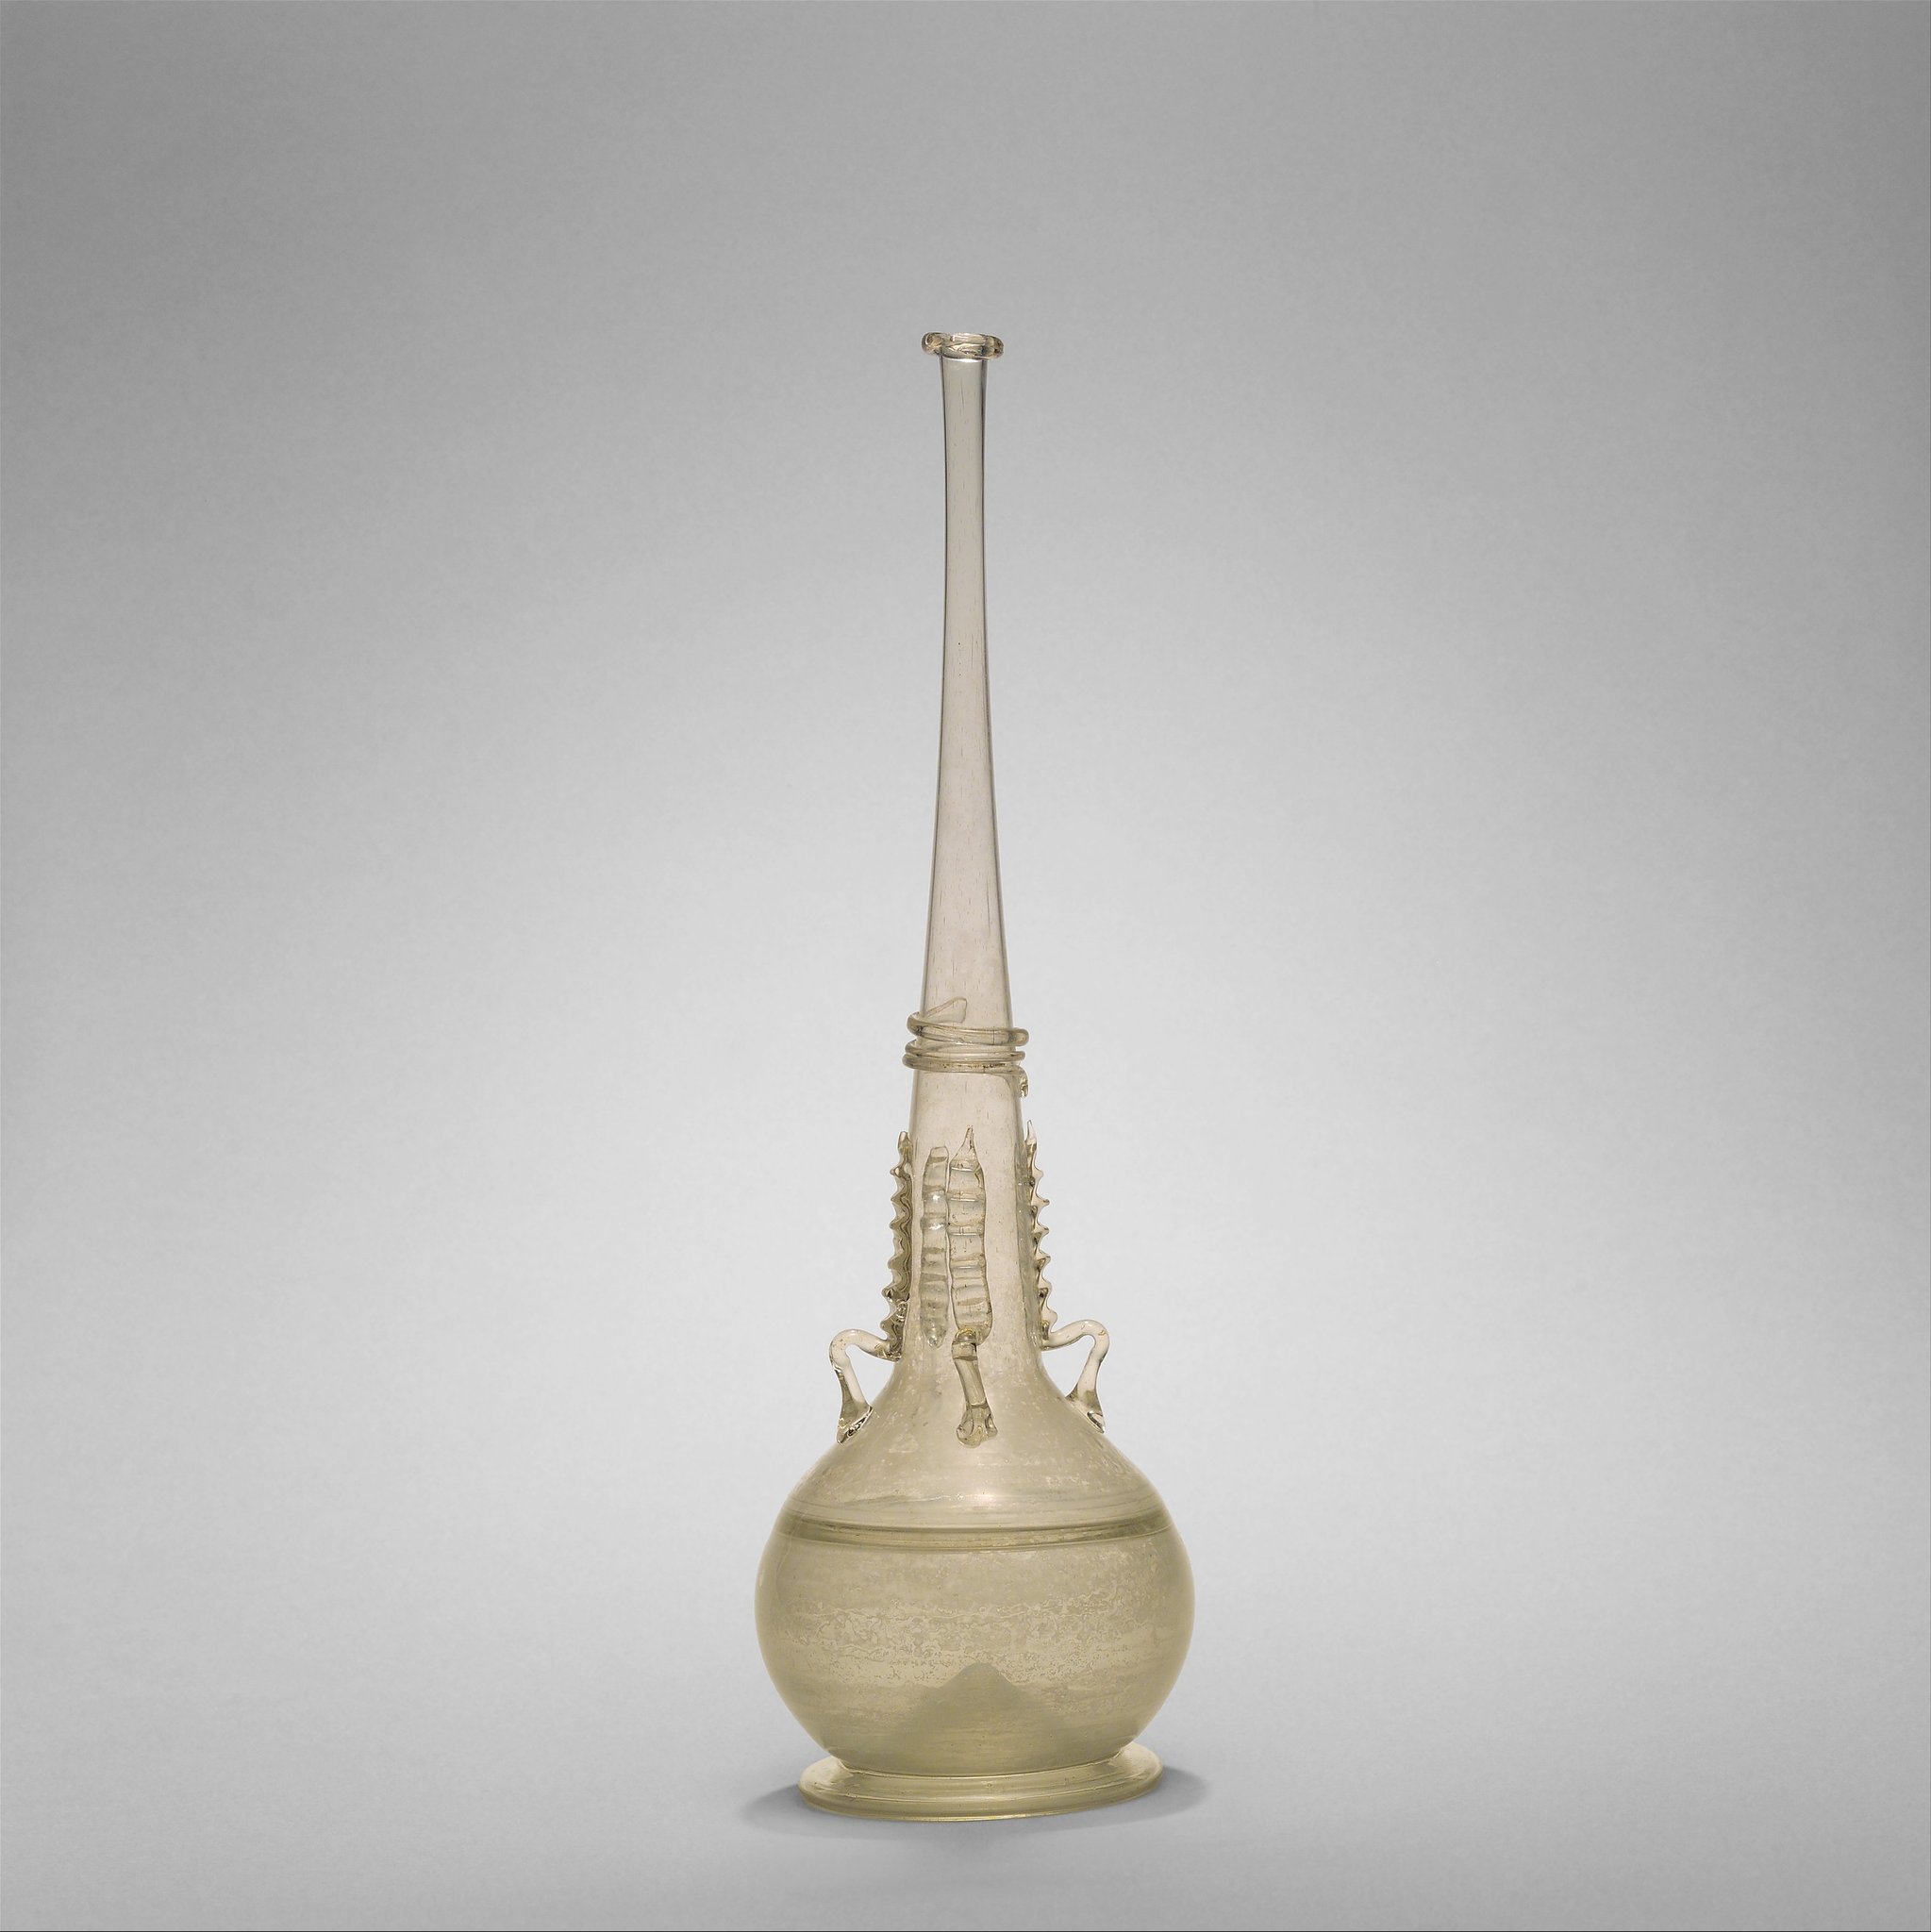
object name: sprinkler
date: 1701-1900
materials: glass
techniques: glassblowing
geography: iran